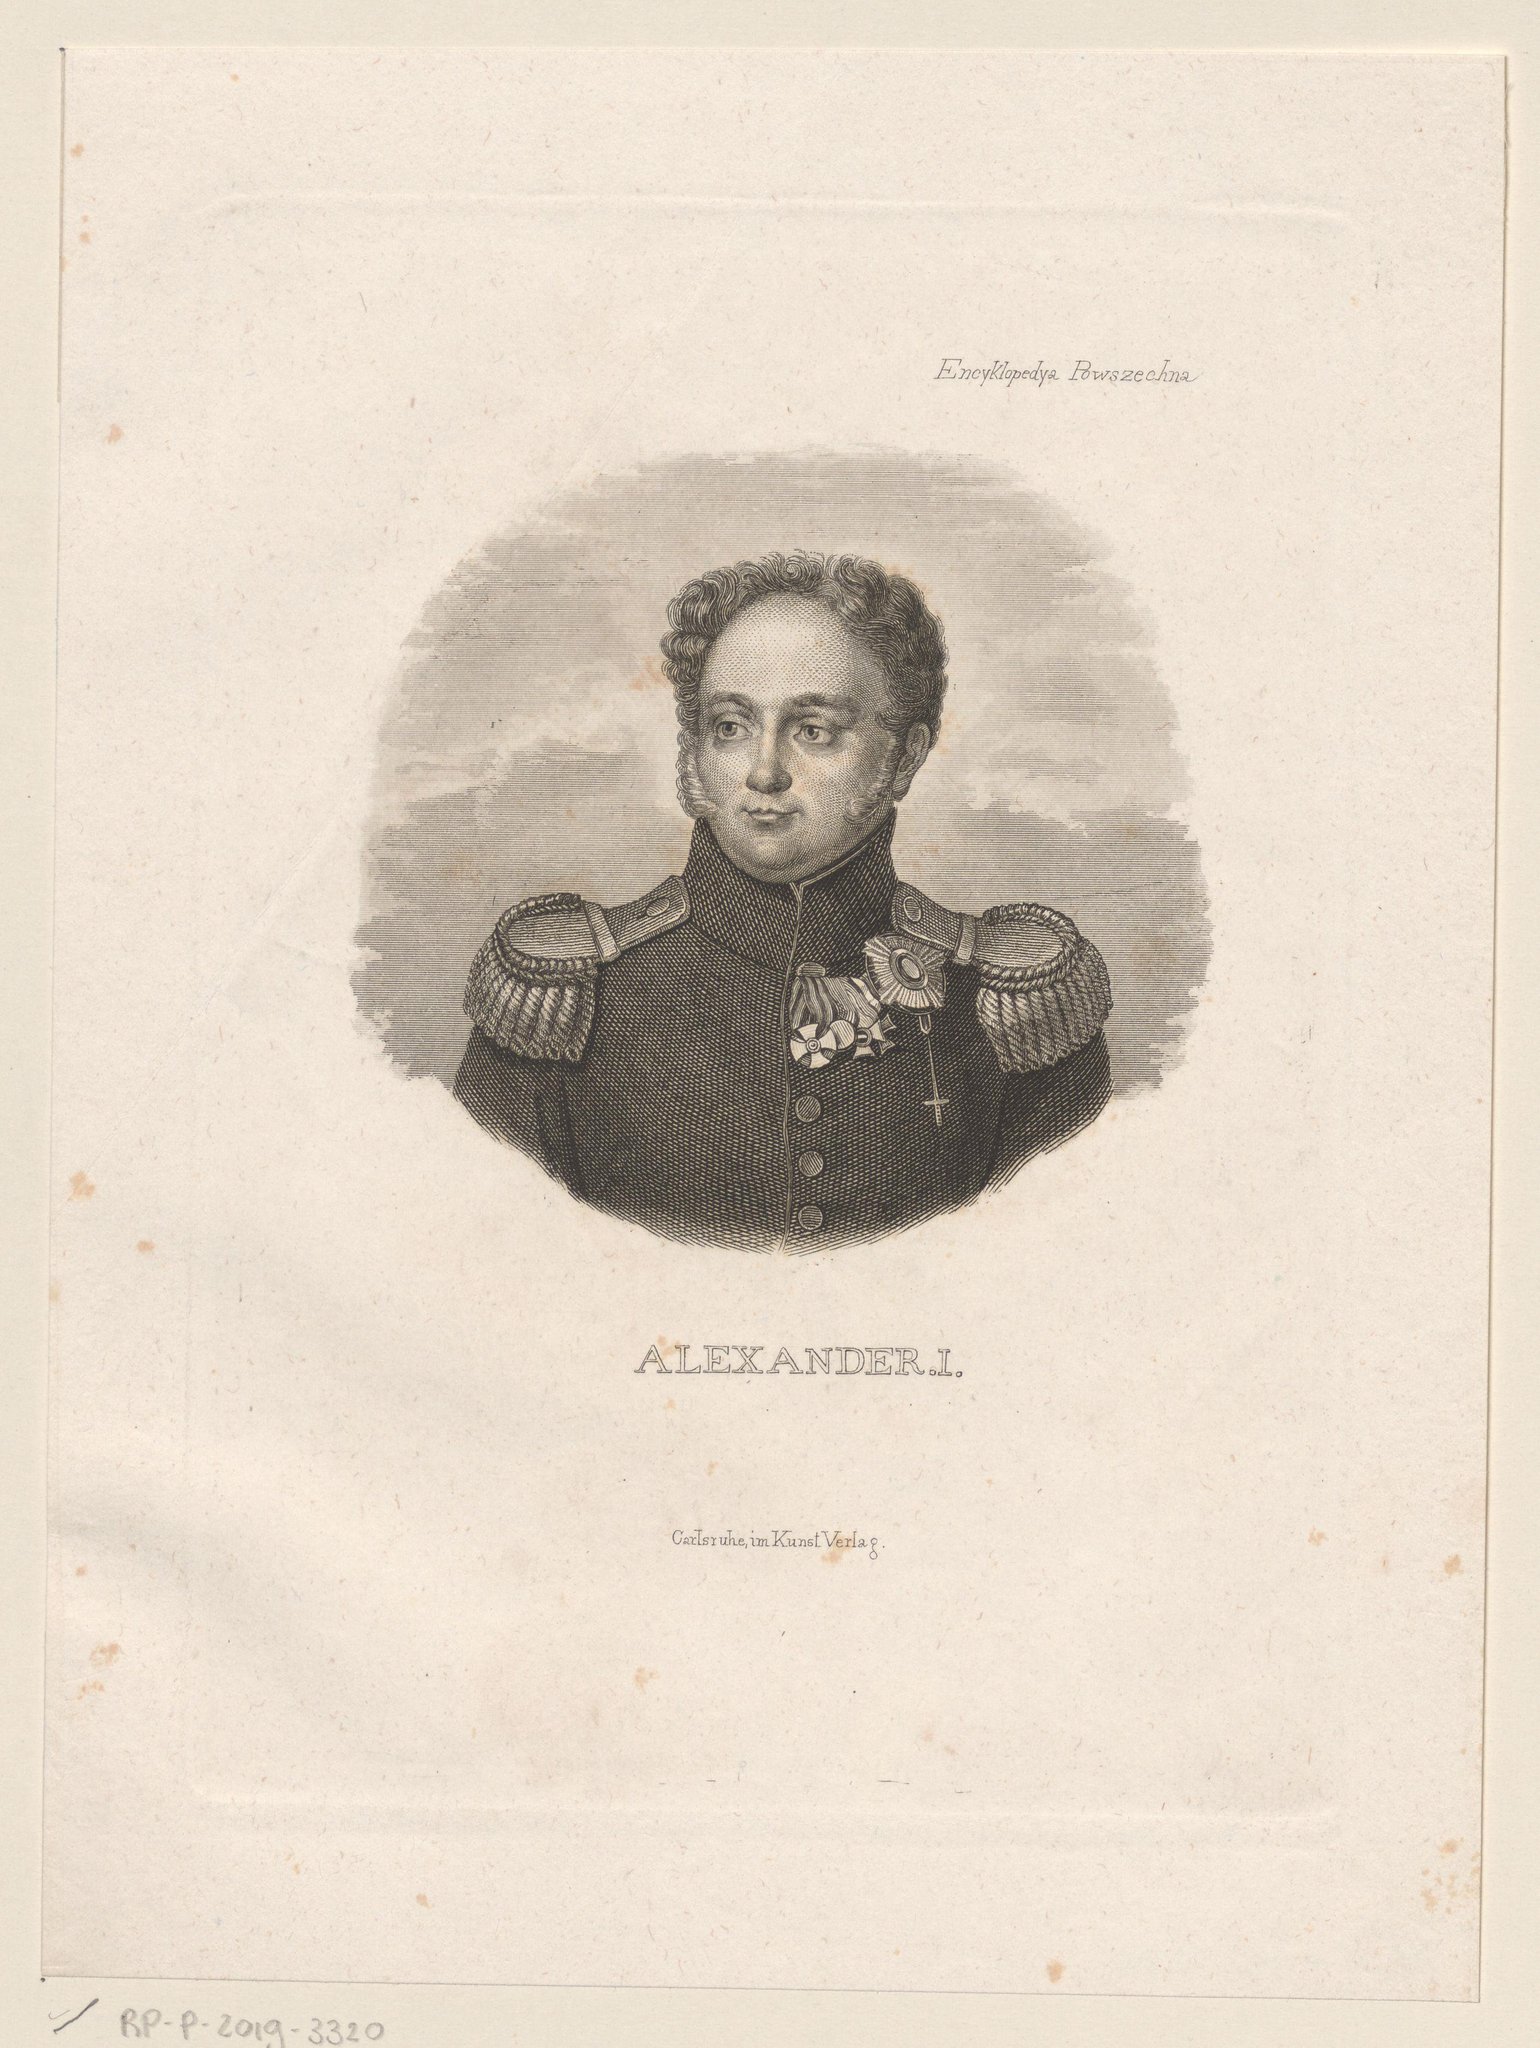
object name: print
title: Portret van Alexander I, tsaar van Rusland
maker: Anonymous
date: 1836-1839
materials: paper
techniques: engraving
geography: karlsruhe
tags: alexander i (tsaar van rusland), historical persons, emperor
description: Prent mogelijk uit: Encyklopedya powszechna. Warschau: August Emmanuel Gücksberg, 1836-1839.